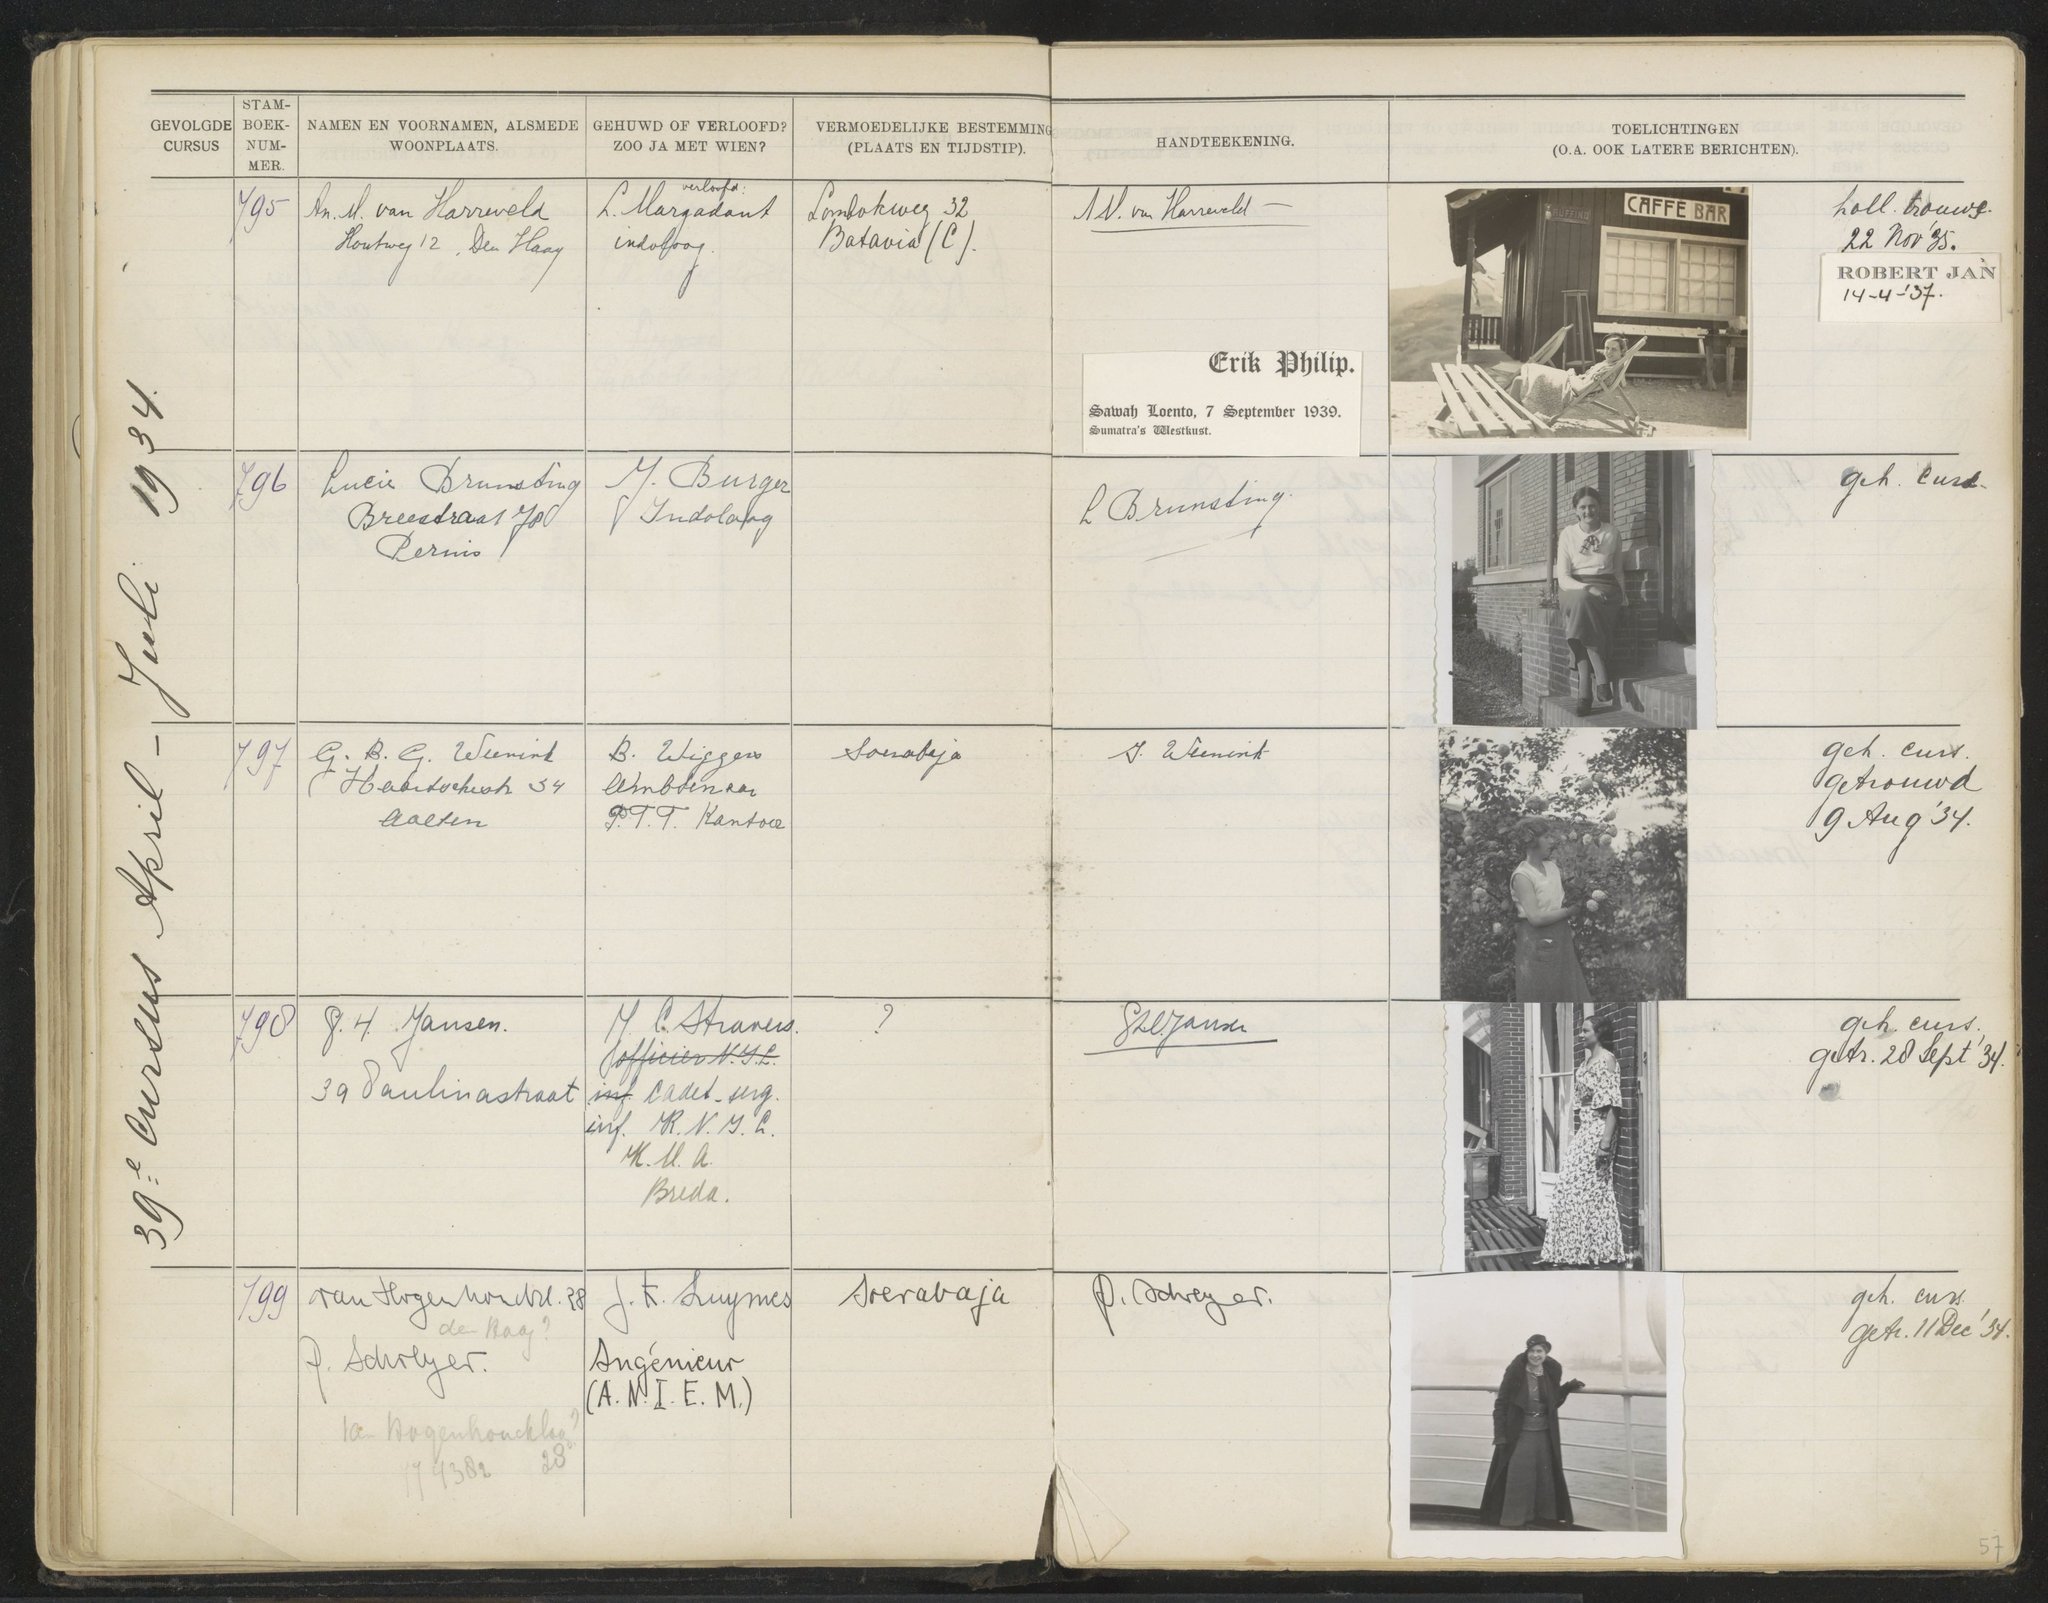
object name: photograph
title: Blad 57 uit Stamboek van de leerlingen der Koloniale School voor Meisjes en Vrouwen te 's-Gravenhage deel II (1930-1949)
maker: Anonymous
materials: paper, photographic support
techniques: photography, printing, writing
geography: the hague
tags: further education (+ pupil), further education, the hague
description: Twee pagina's met gegevens van de deelnemers aan de 39e driemaandelijkse cursus van april tot juli 1934, stamboeknummers 795 tot en met 799. Onderdeel van Stamboek van de leerlingen der Koloniale School voor Meisjes en Vrouwen te 's-Gravenhage deel II (1930-1949).